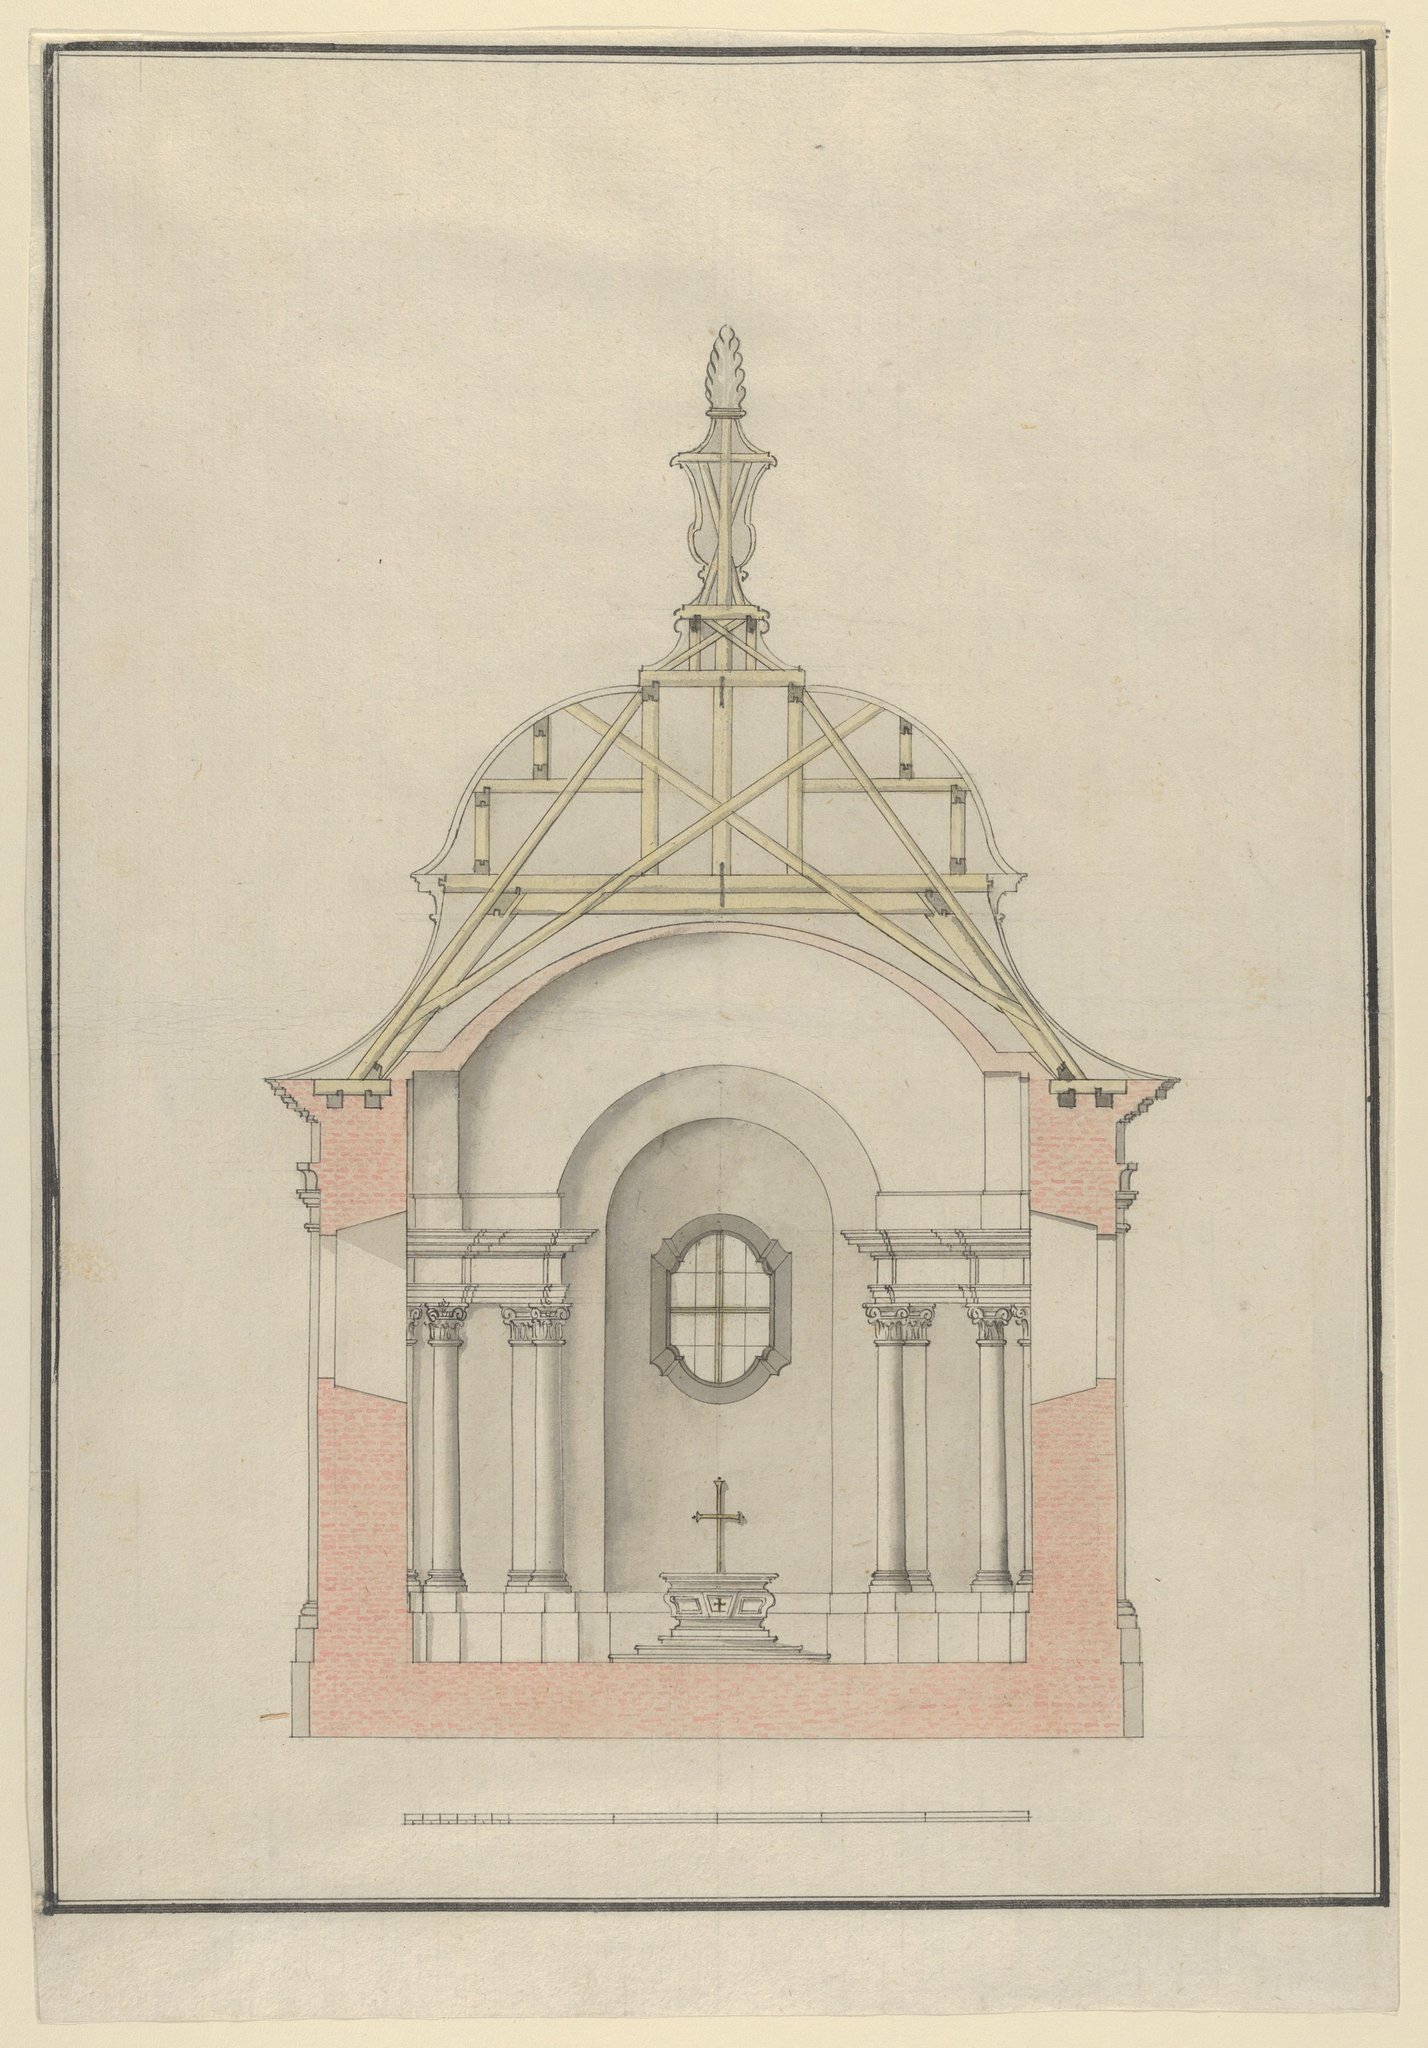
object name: print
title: Cross Section of a Baroque Church or Chapel with a Bell-shaped Roof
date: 1650-1725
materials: ink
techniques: pen, wash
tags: churches,cross